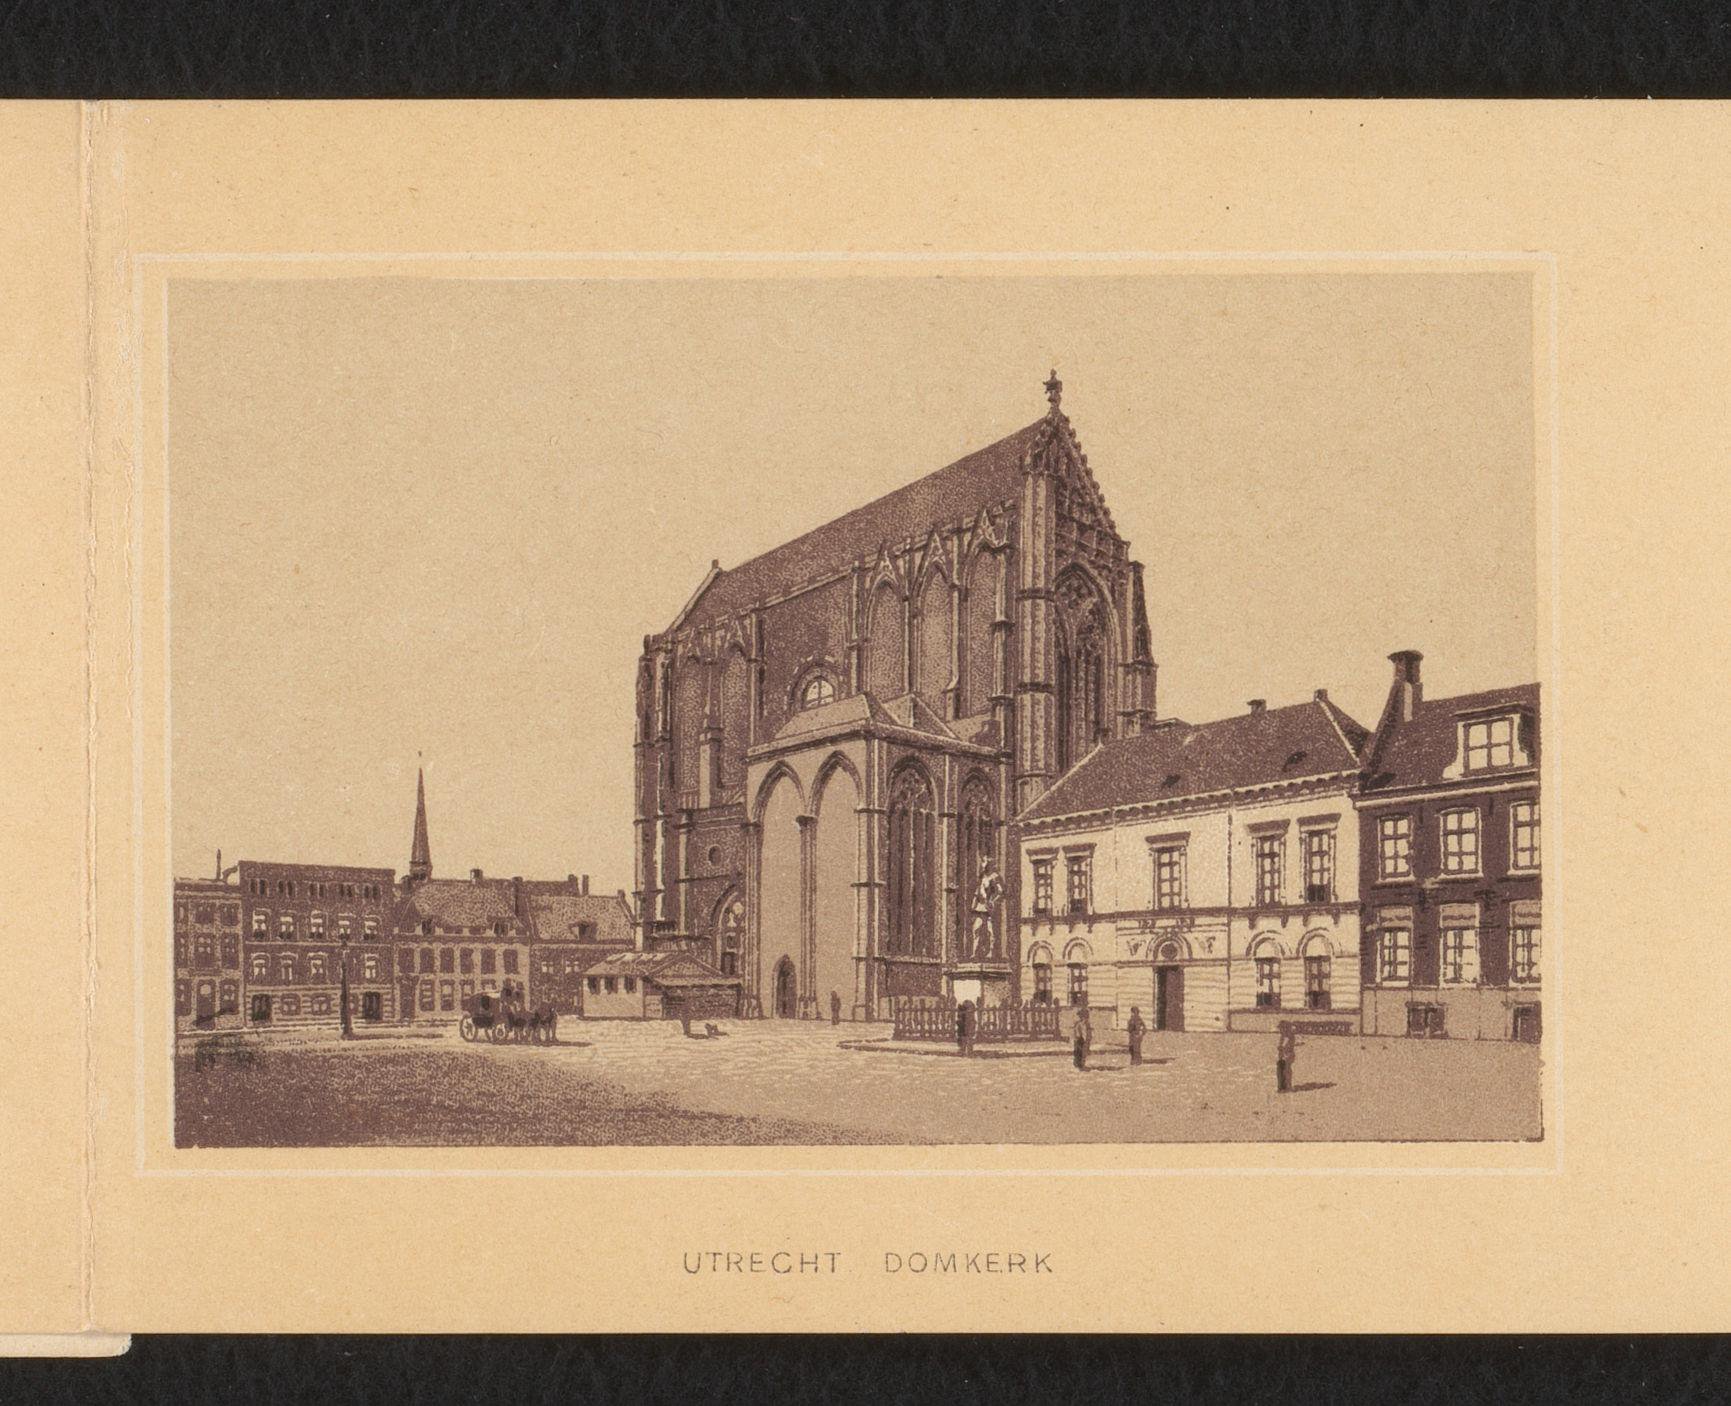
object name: print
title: Utrecht. Domkerk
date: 1887-1891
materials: paper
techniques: lithograph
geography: amsterdam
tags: city-view, and landscape with man-made constructions, church (exterior), monument, statue